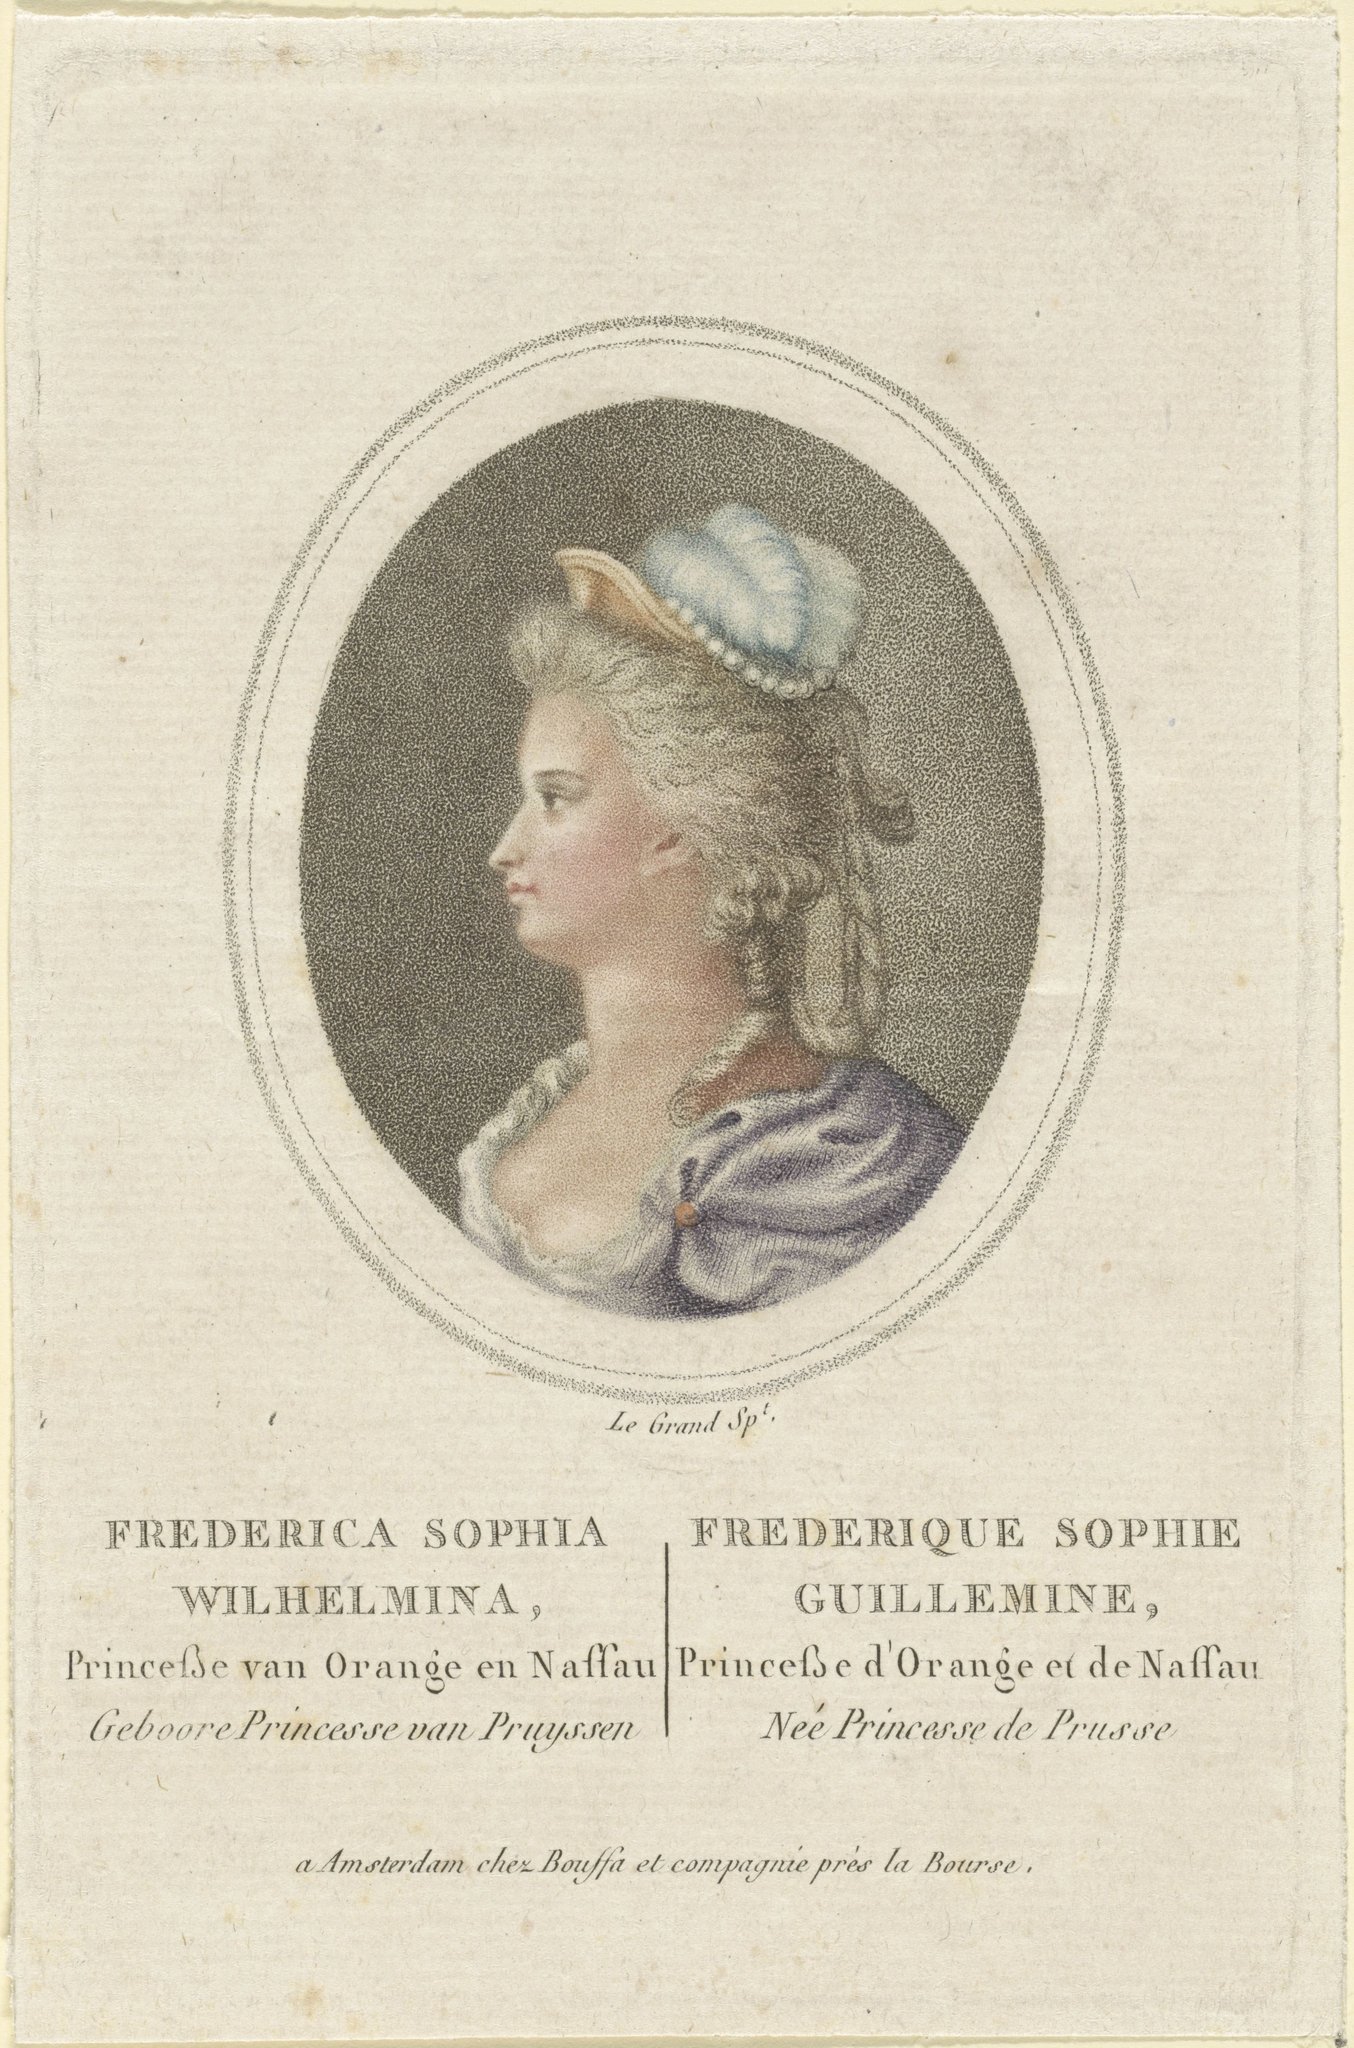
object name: print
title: Portret van Wilhelmina van Pruisen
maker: le grand (prentmaker)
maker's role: print maker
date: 1767-1849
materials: paper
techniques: aquatint, engraving, etching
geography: amsterdam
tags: berlin, painter, draughtsman, wilhelmina of prussia (princess of orange)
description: Portret van Wilhelmina in een ovaal. In de ondermarge haar naam en titels in het Nederlands en in het Frans.